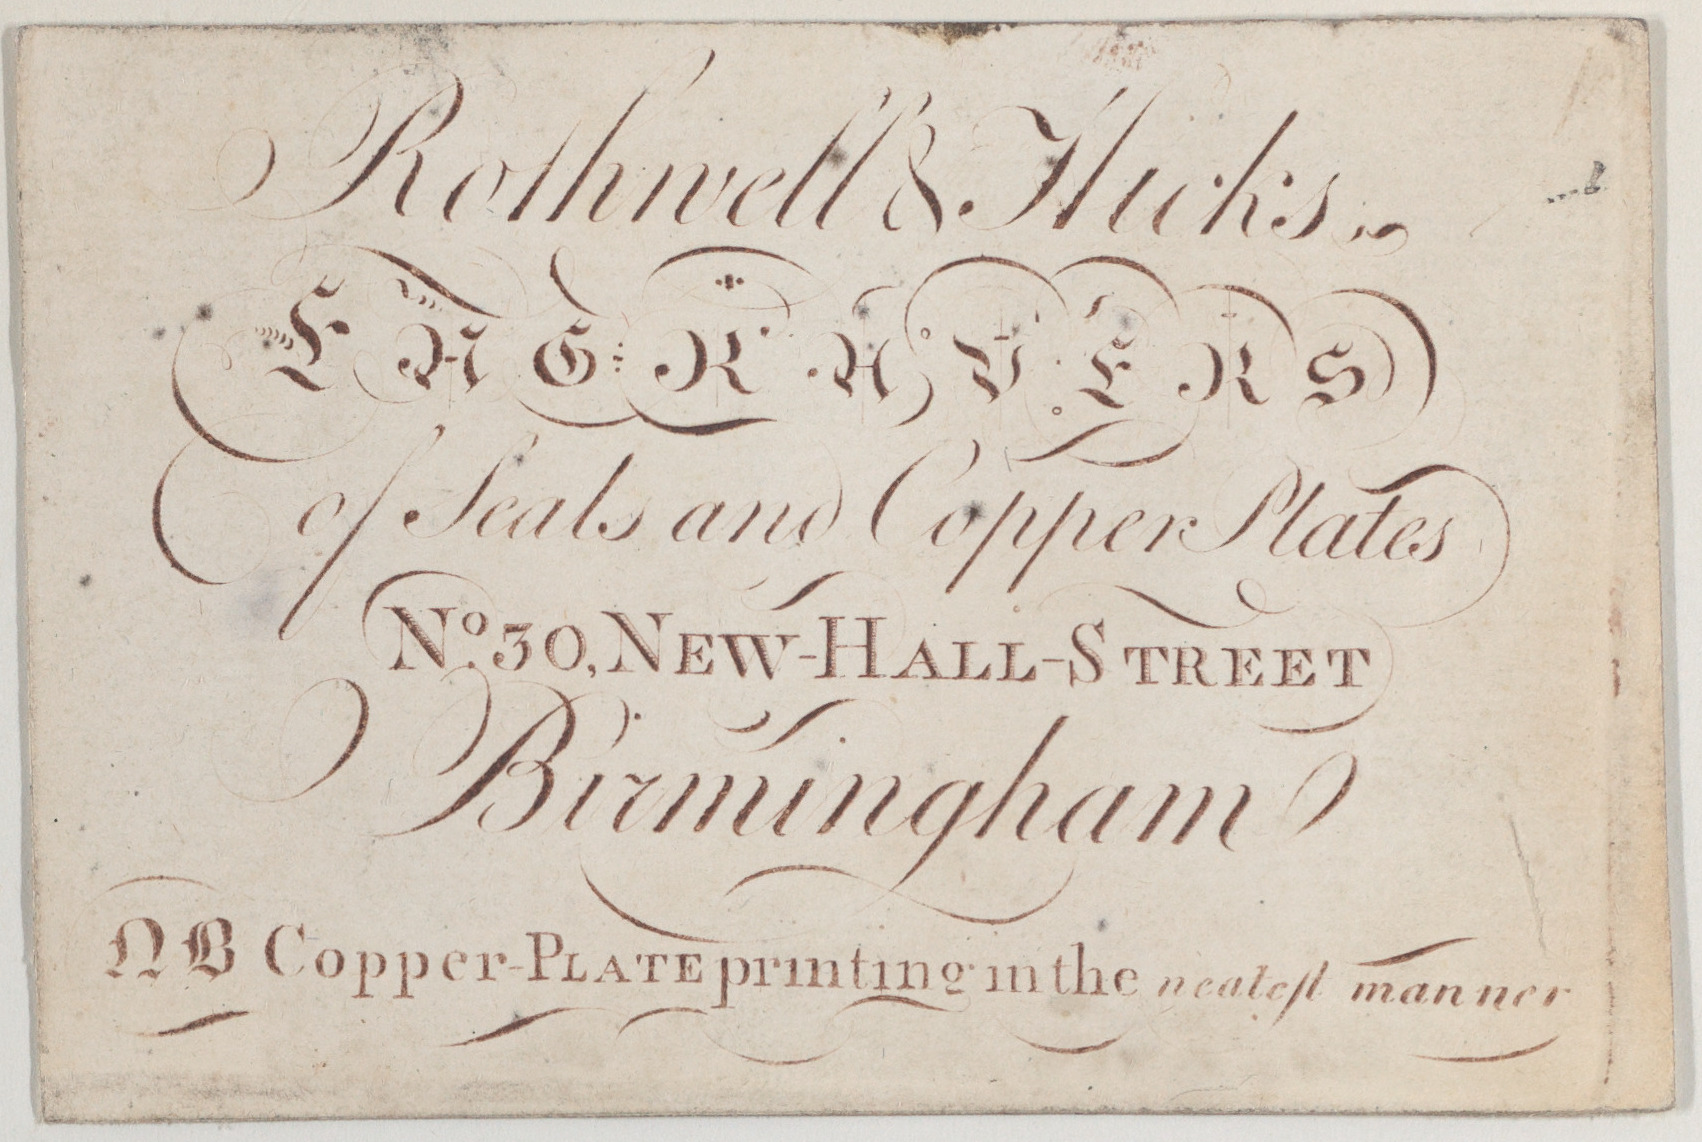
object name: print, trade card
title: Trade Card for Rothwell & Hicks, engravers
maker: anonymous, british, 18th century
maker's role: artist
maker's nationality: british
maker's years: 1700-1800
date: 1701-1800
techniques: engraving